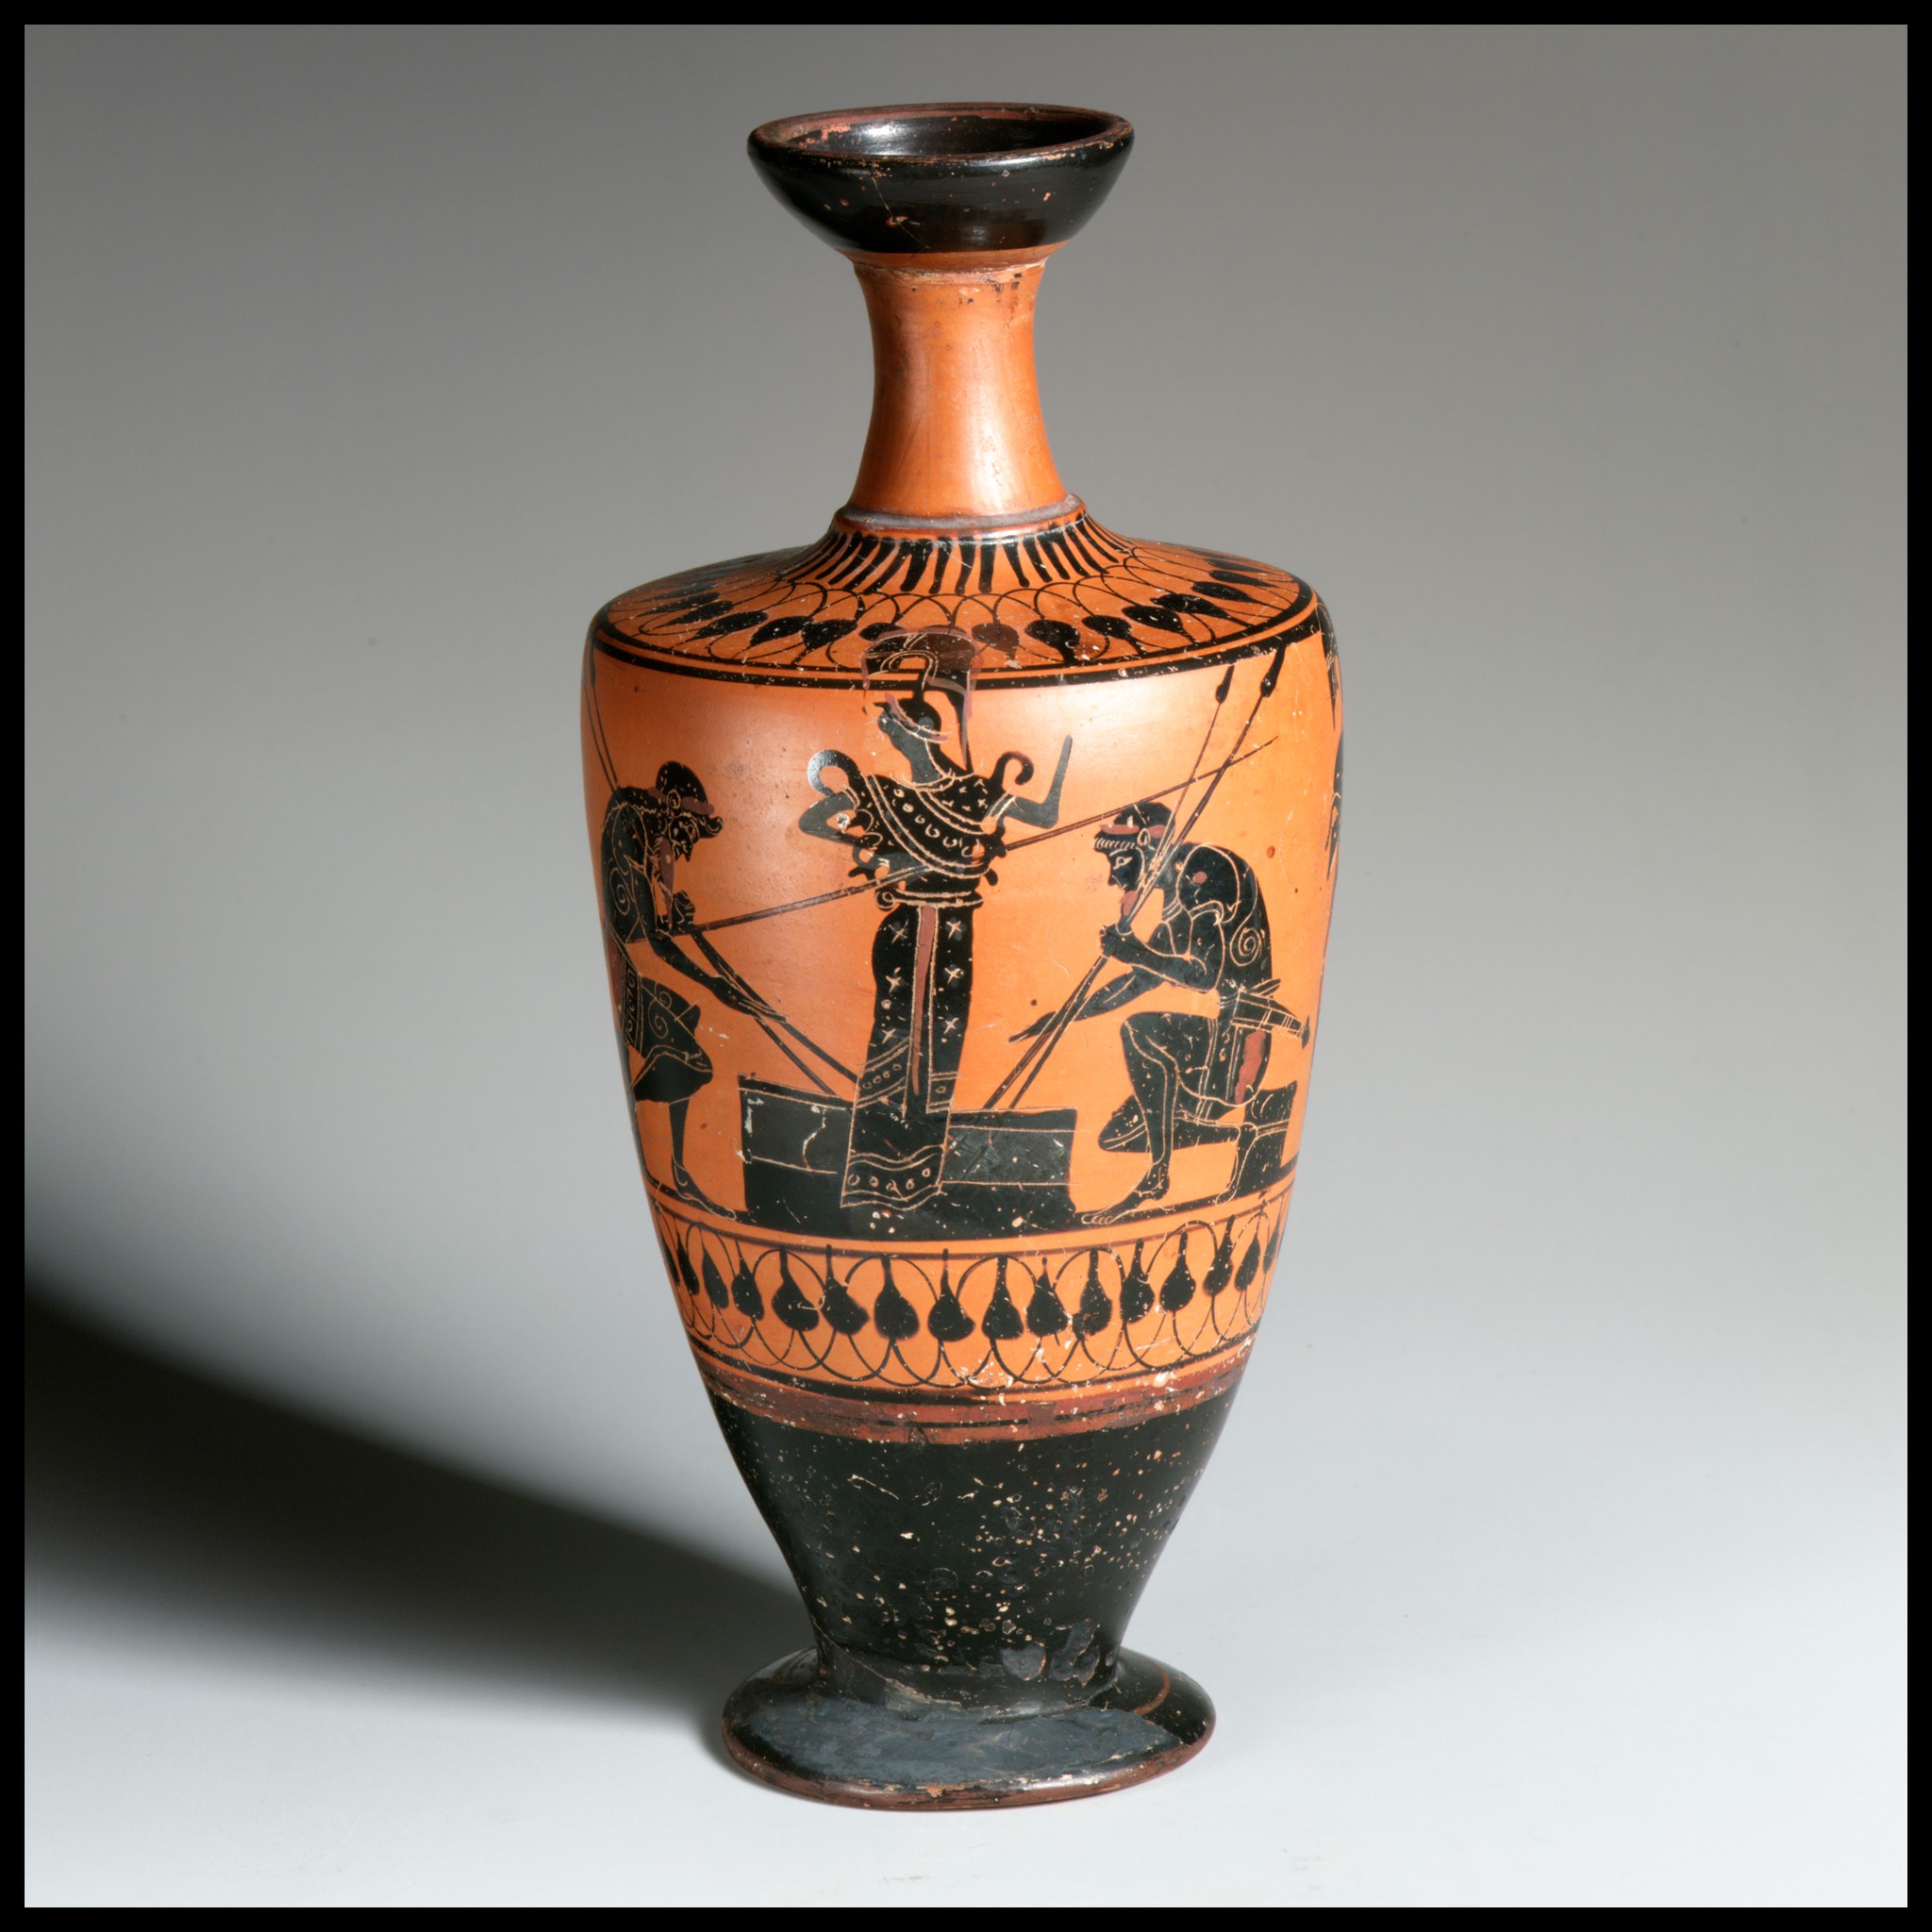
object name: lekythos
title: Terracotta lekythos (oil flask)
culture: greek, attic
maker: painter of vatican g.31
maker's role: artist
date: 534-501 BCE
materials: terracotta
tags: trojan war,athena,achilles,games,ajax